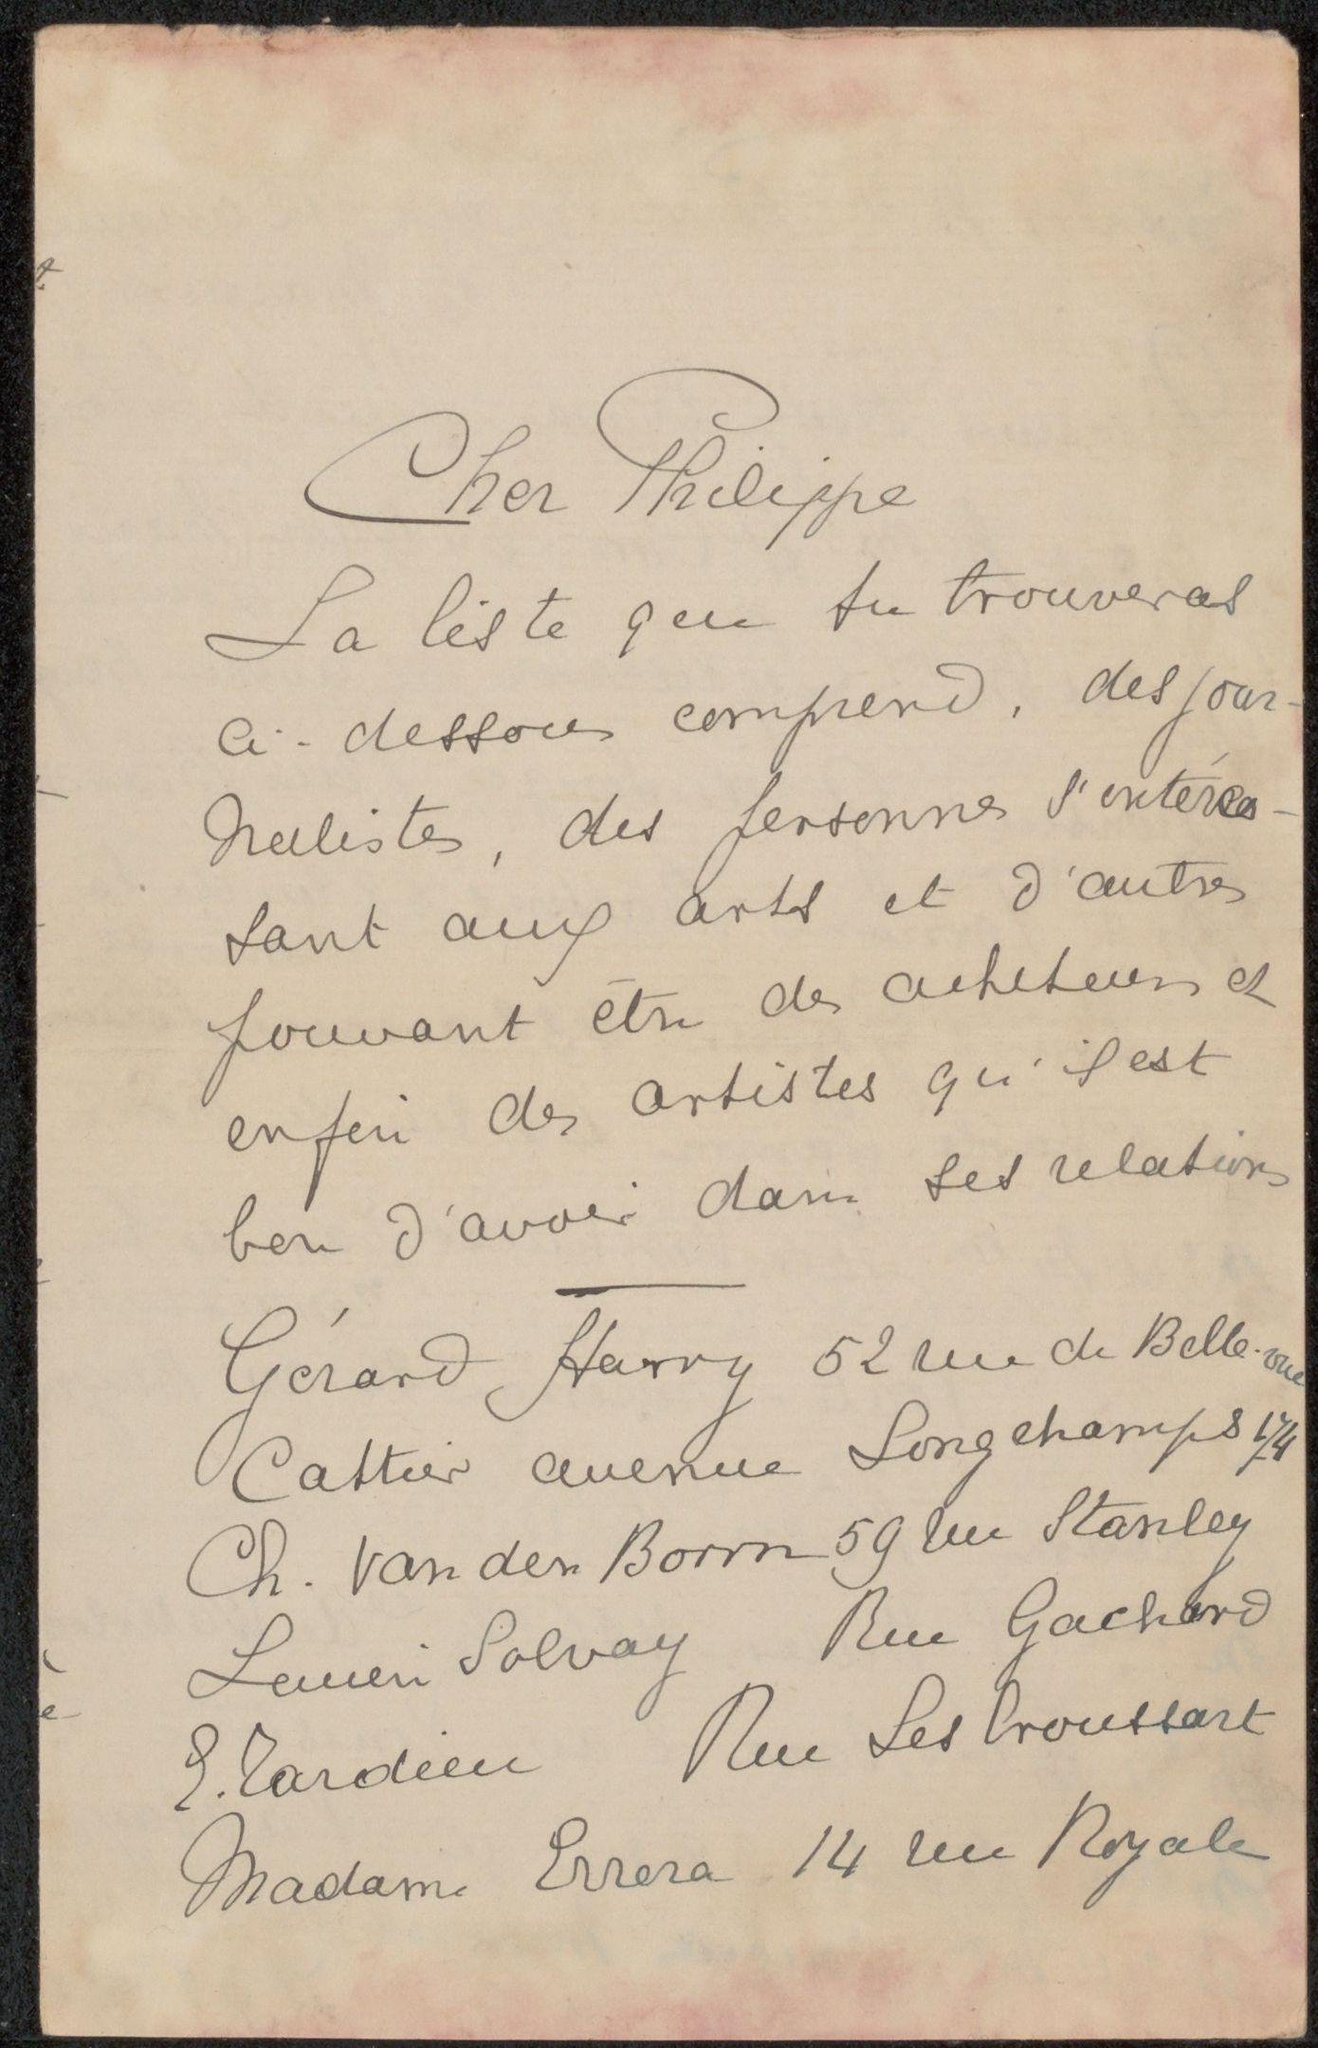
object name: letter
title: Brief aan Philip Zilcken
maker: hélène van goethem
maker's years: 1866-1919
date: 1913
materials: ink, paper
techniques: pen, writing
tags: the hague, painter, draughtsman, philip zilcken, brussels